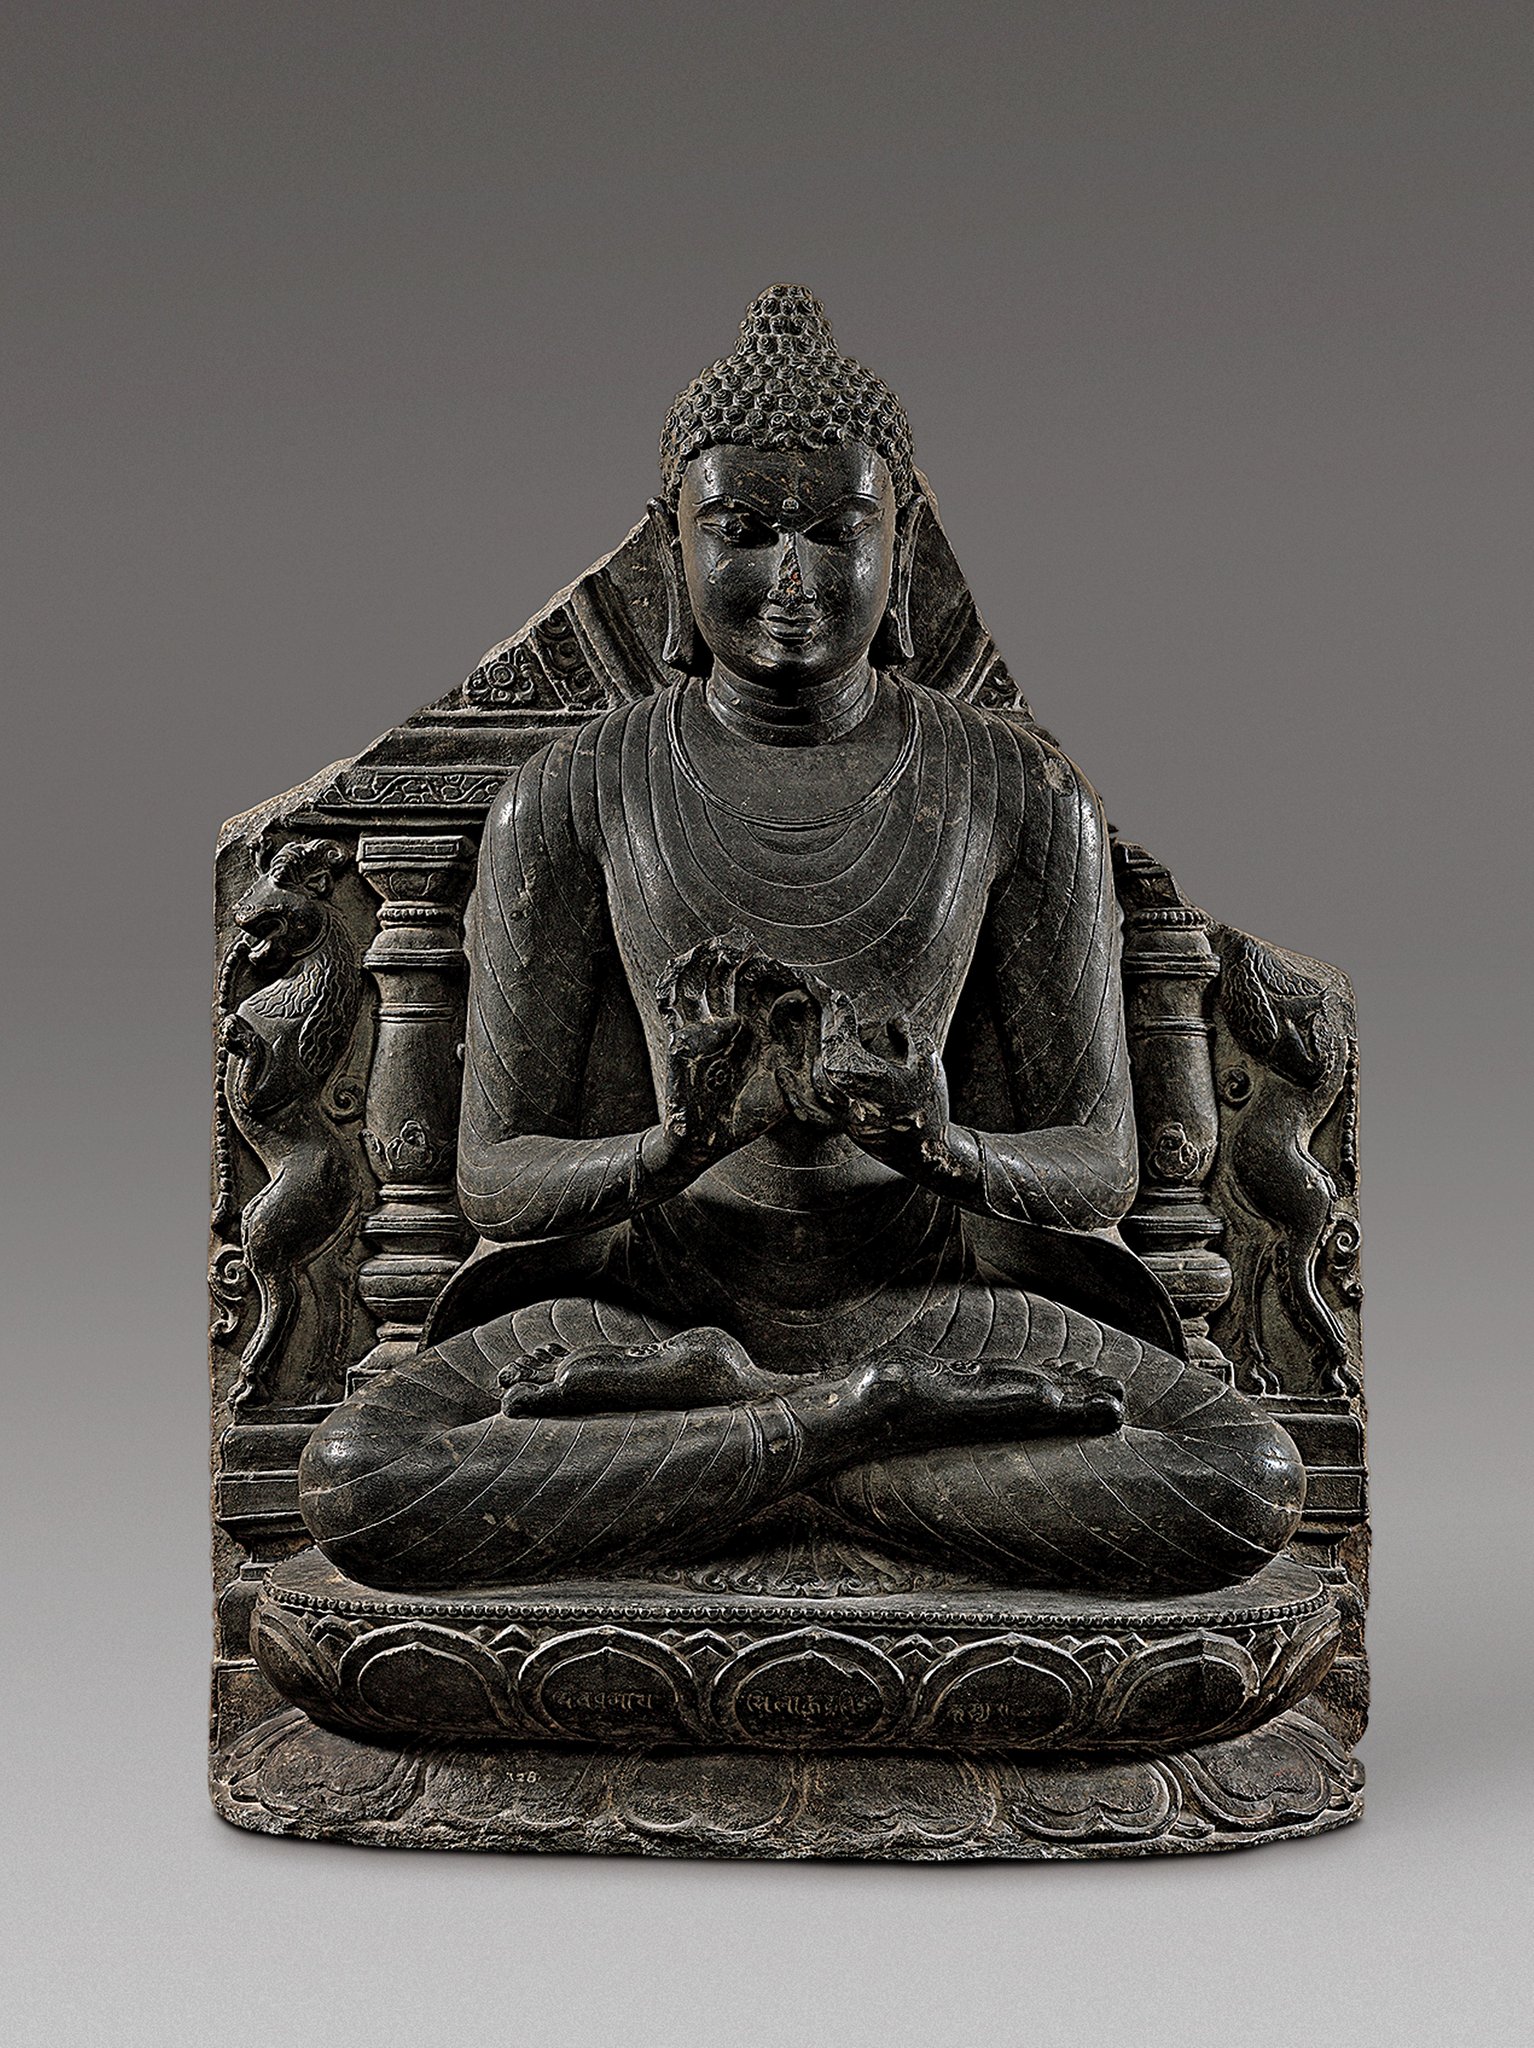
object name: figure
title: Buddha Preaching the First Sermon at Sarnath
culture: indian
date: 1001-1100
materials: stone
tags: buddhism,buddha